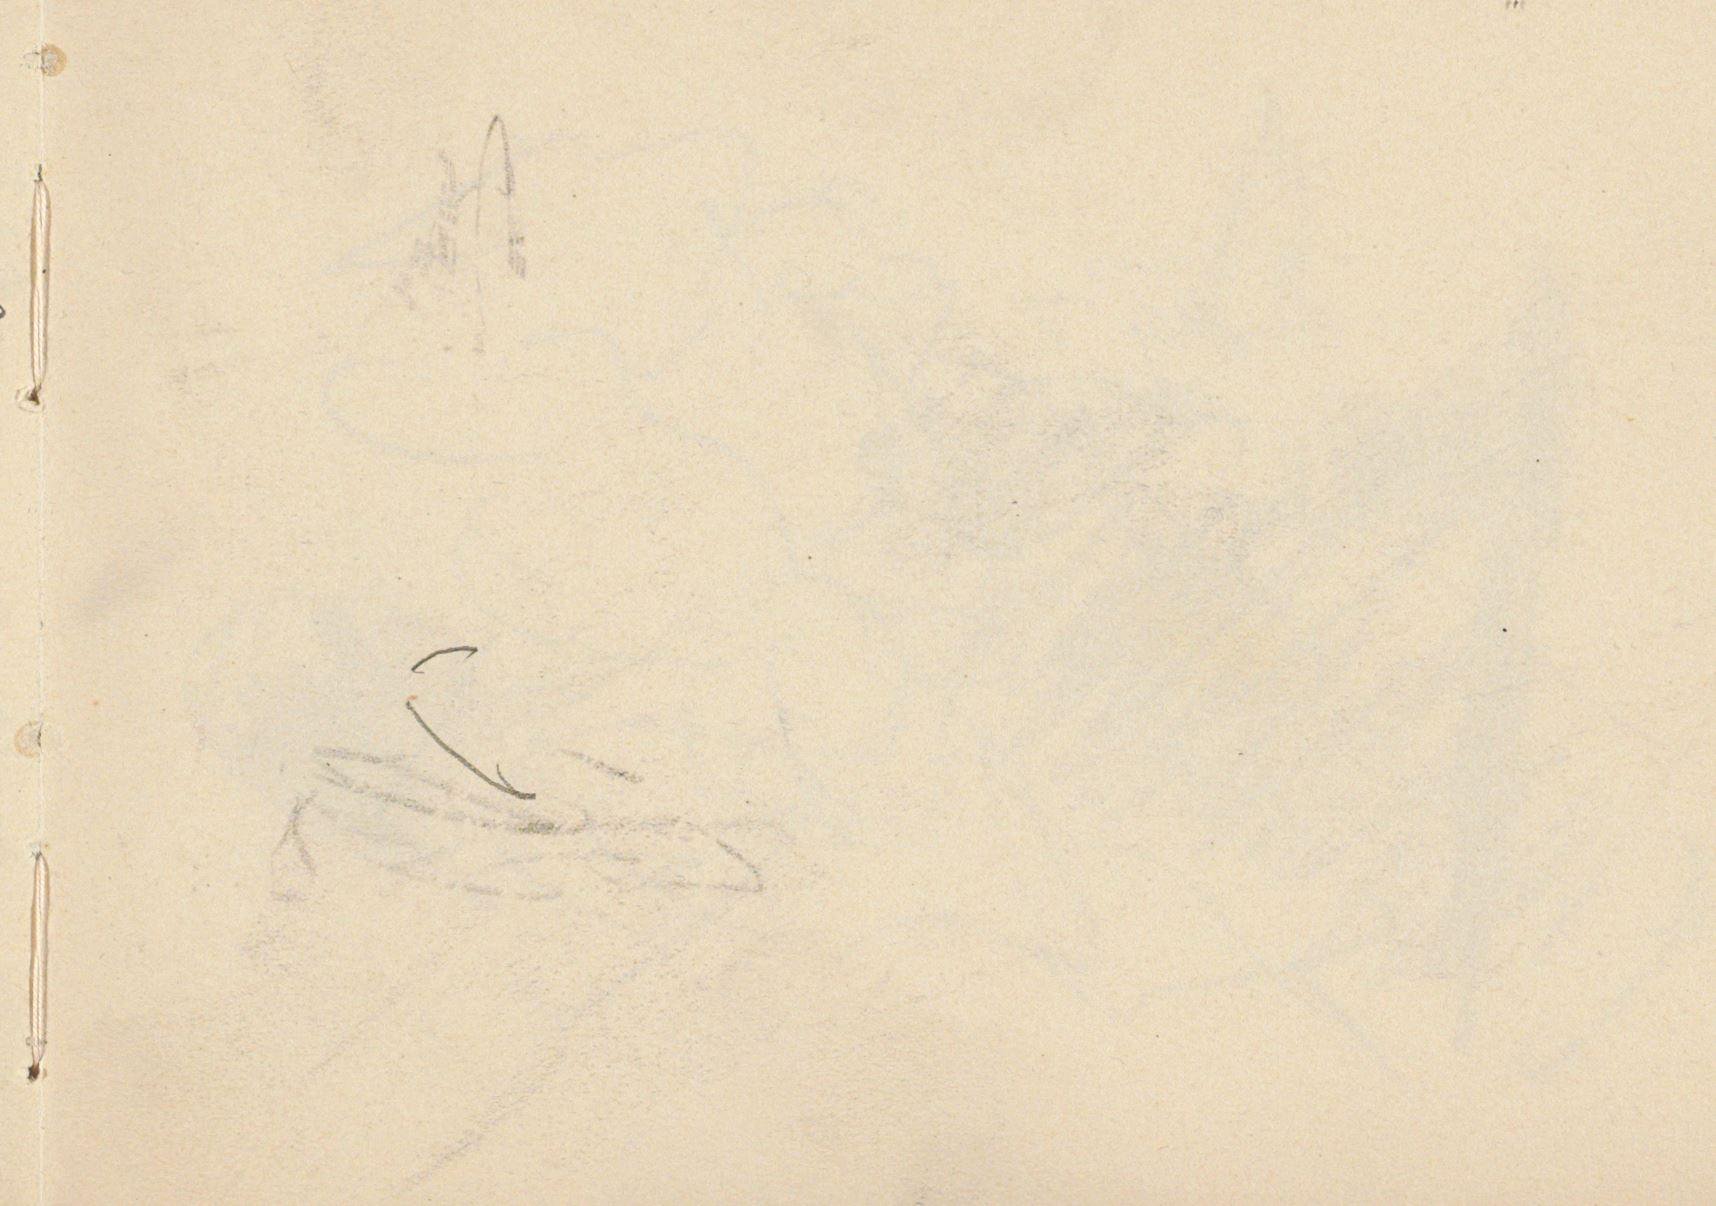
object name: sketchbook leaf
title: Studie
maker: isaac israels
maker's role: draughtsman, painter, print maker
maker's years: 1865-1934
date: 1930-1934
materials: paper, pencil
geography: the hague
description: Pagina 24 uit schetsboek XXXVIII met 45 pagina's.